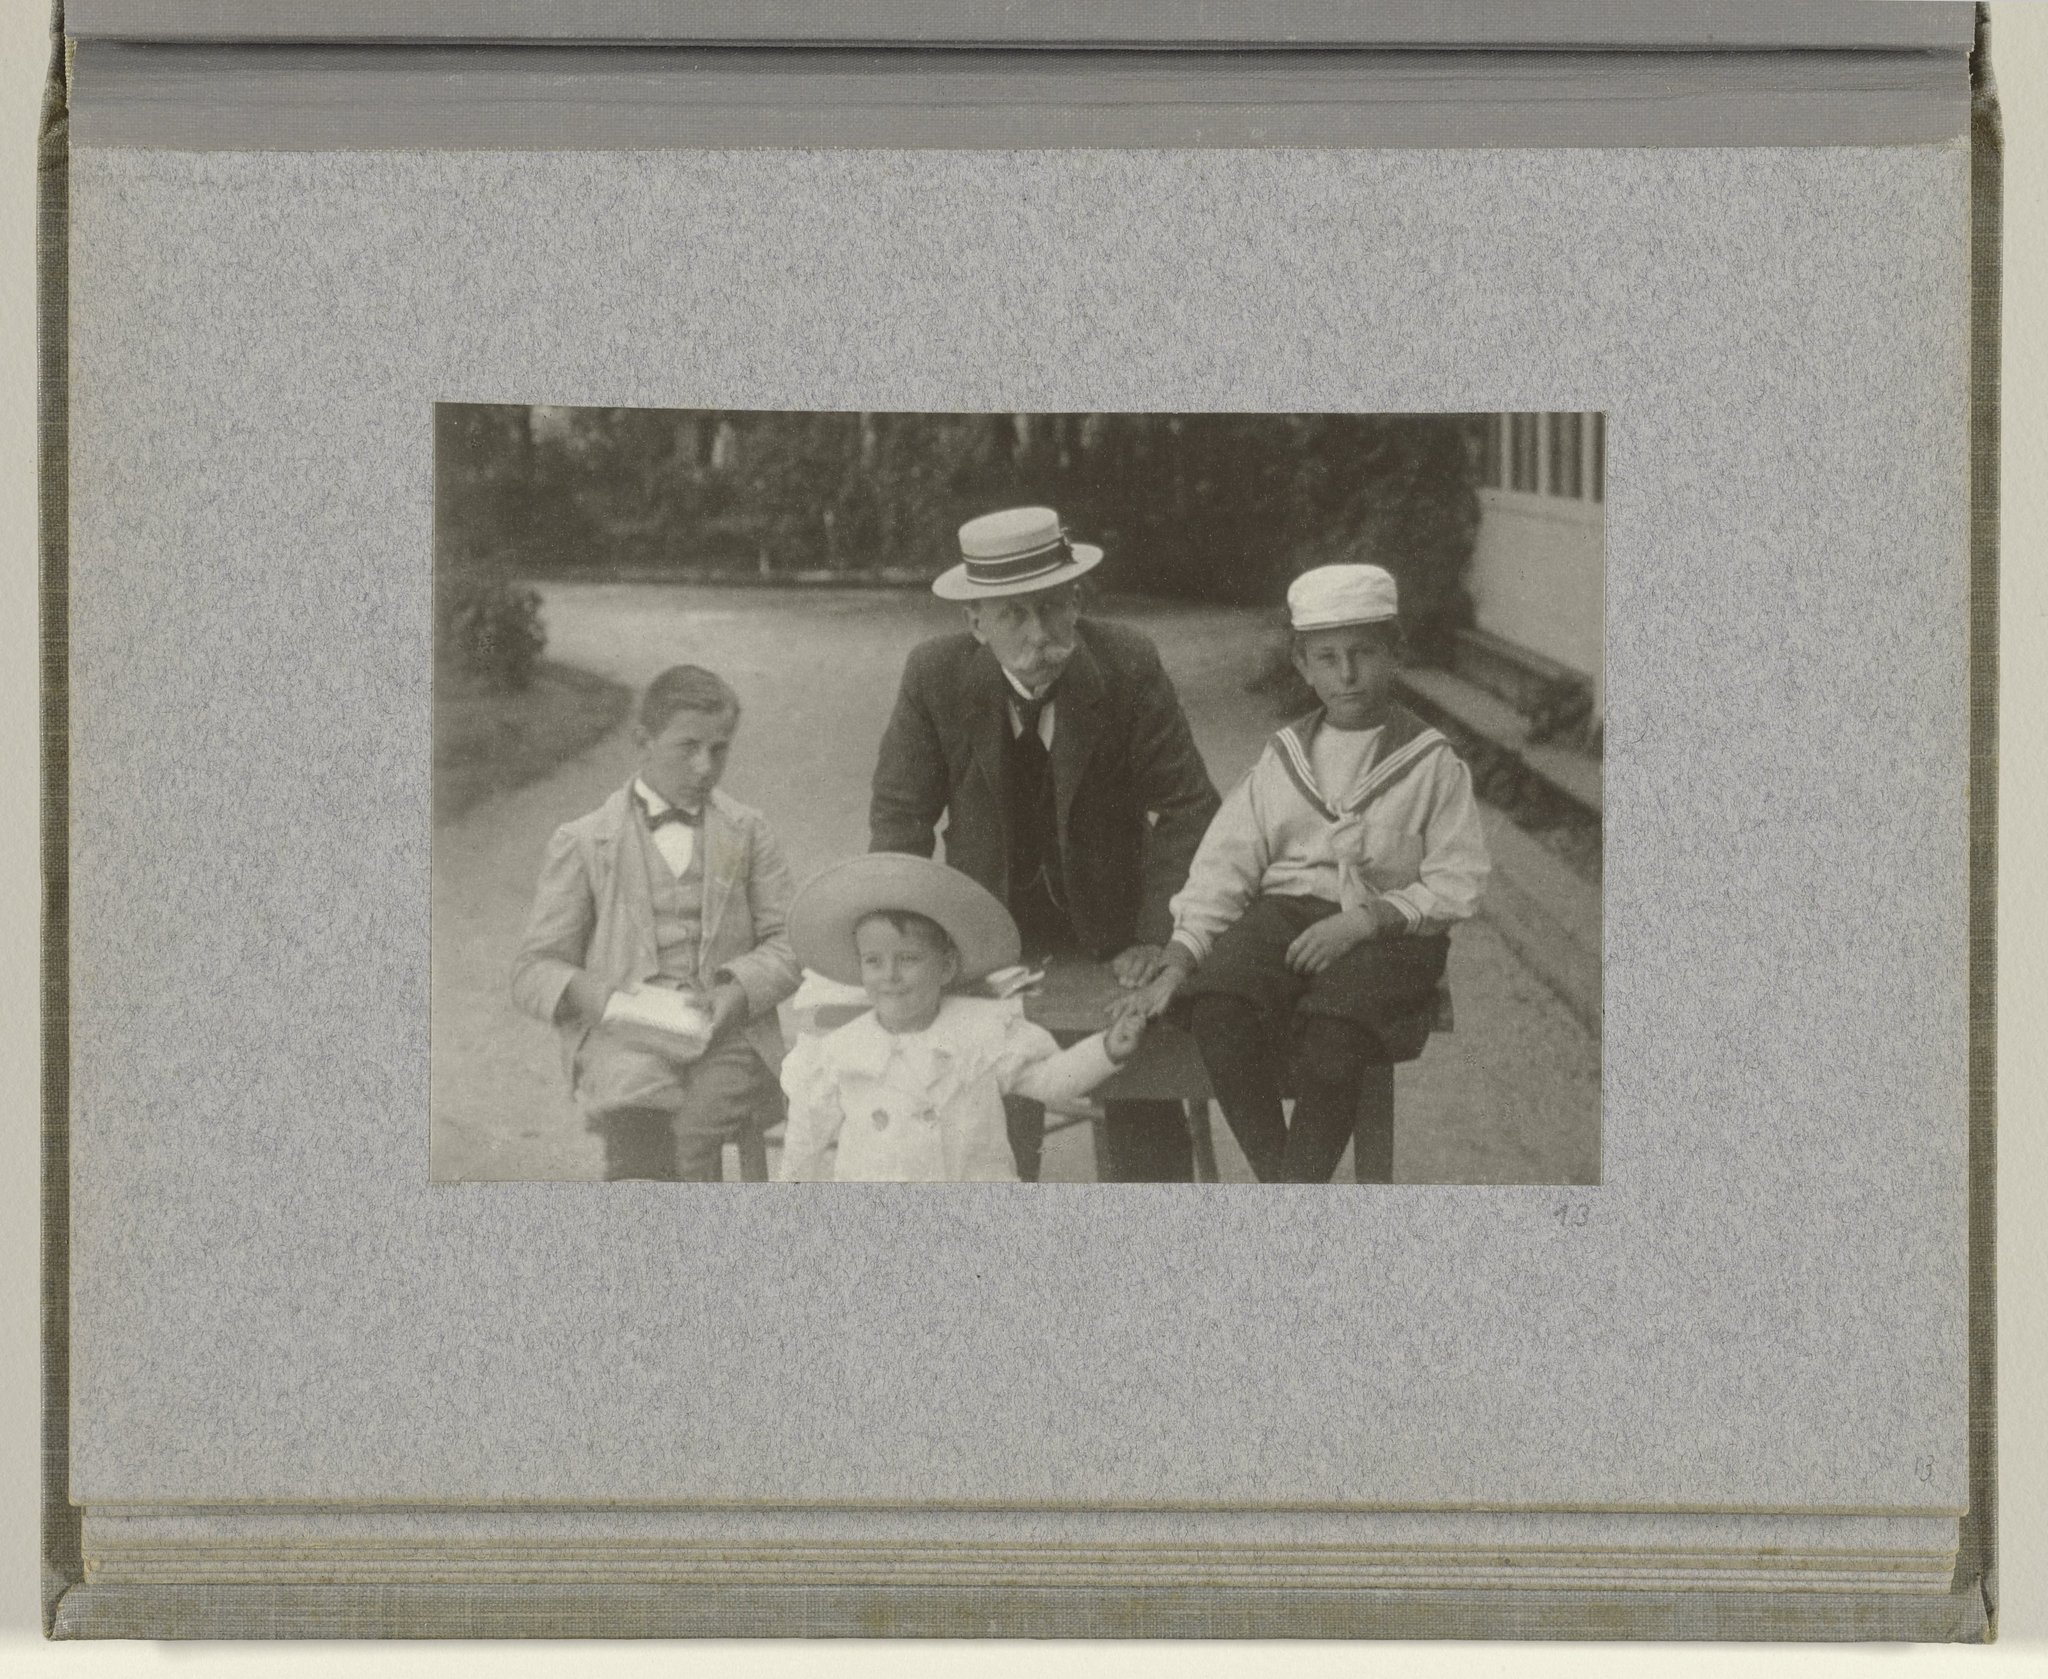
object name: photograph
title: J.B. Aug. Kessler met Dolph en kinderen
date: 1897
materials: paper, photographic support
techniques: gelatin silver print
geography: netherlands